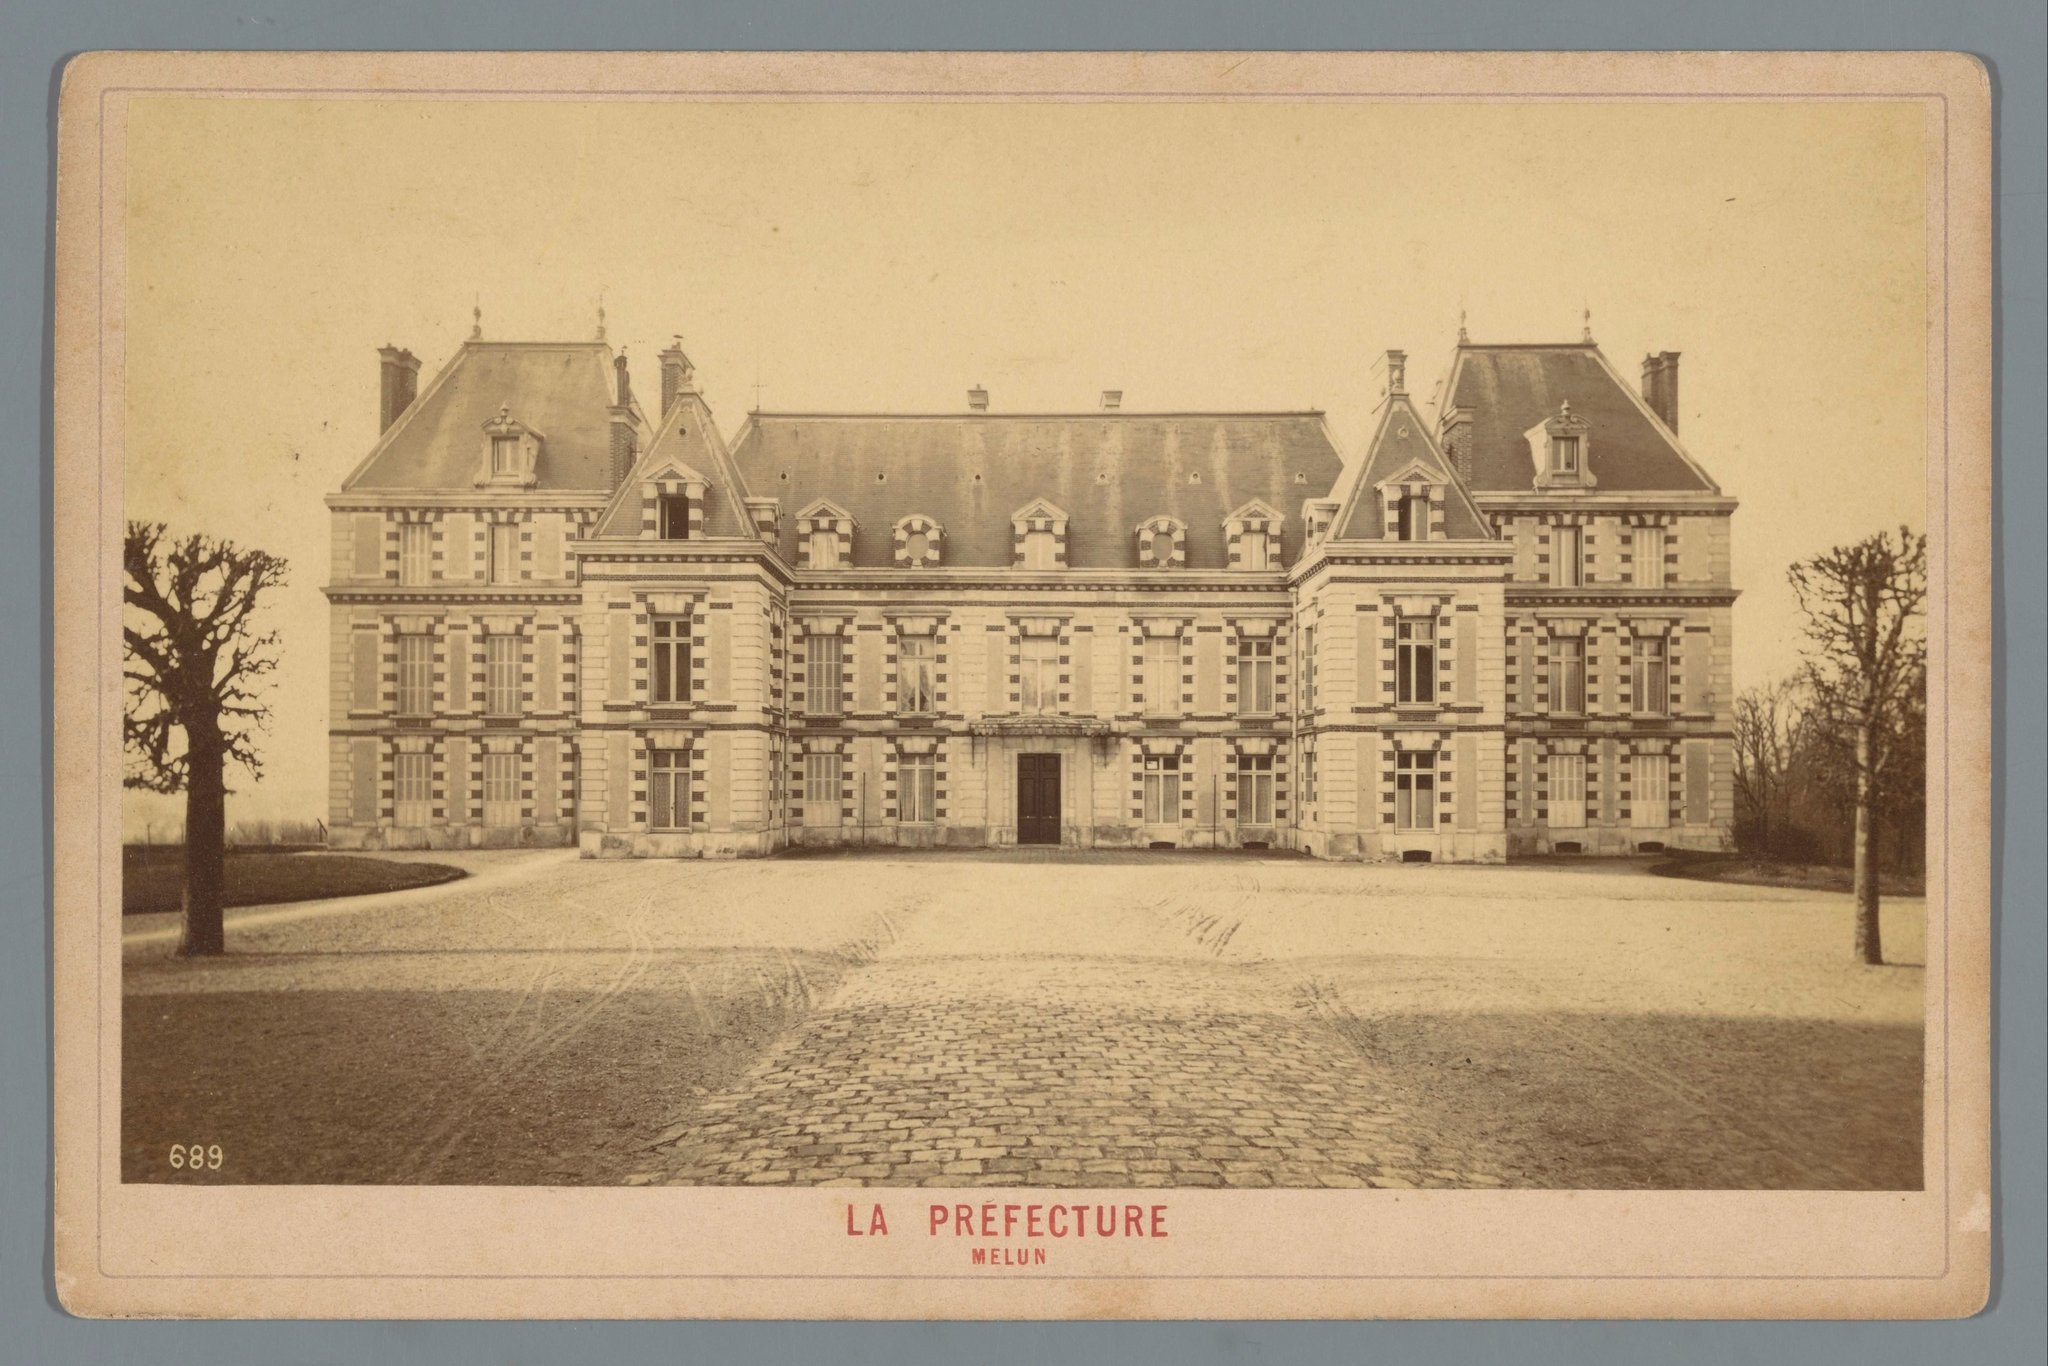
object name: cabinet photograph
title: Gezicht op La Préfecture te Melun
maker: Anonymous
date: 1896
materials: cardboard, photographic support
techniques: albumen print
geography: melun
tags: façade (of house or building)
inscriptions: number: ‘689’, date: ‘22 Avril 1896’